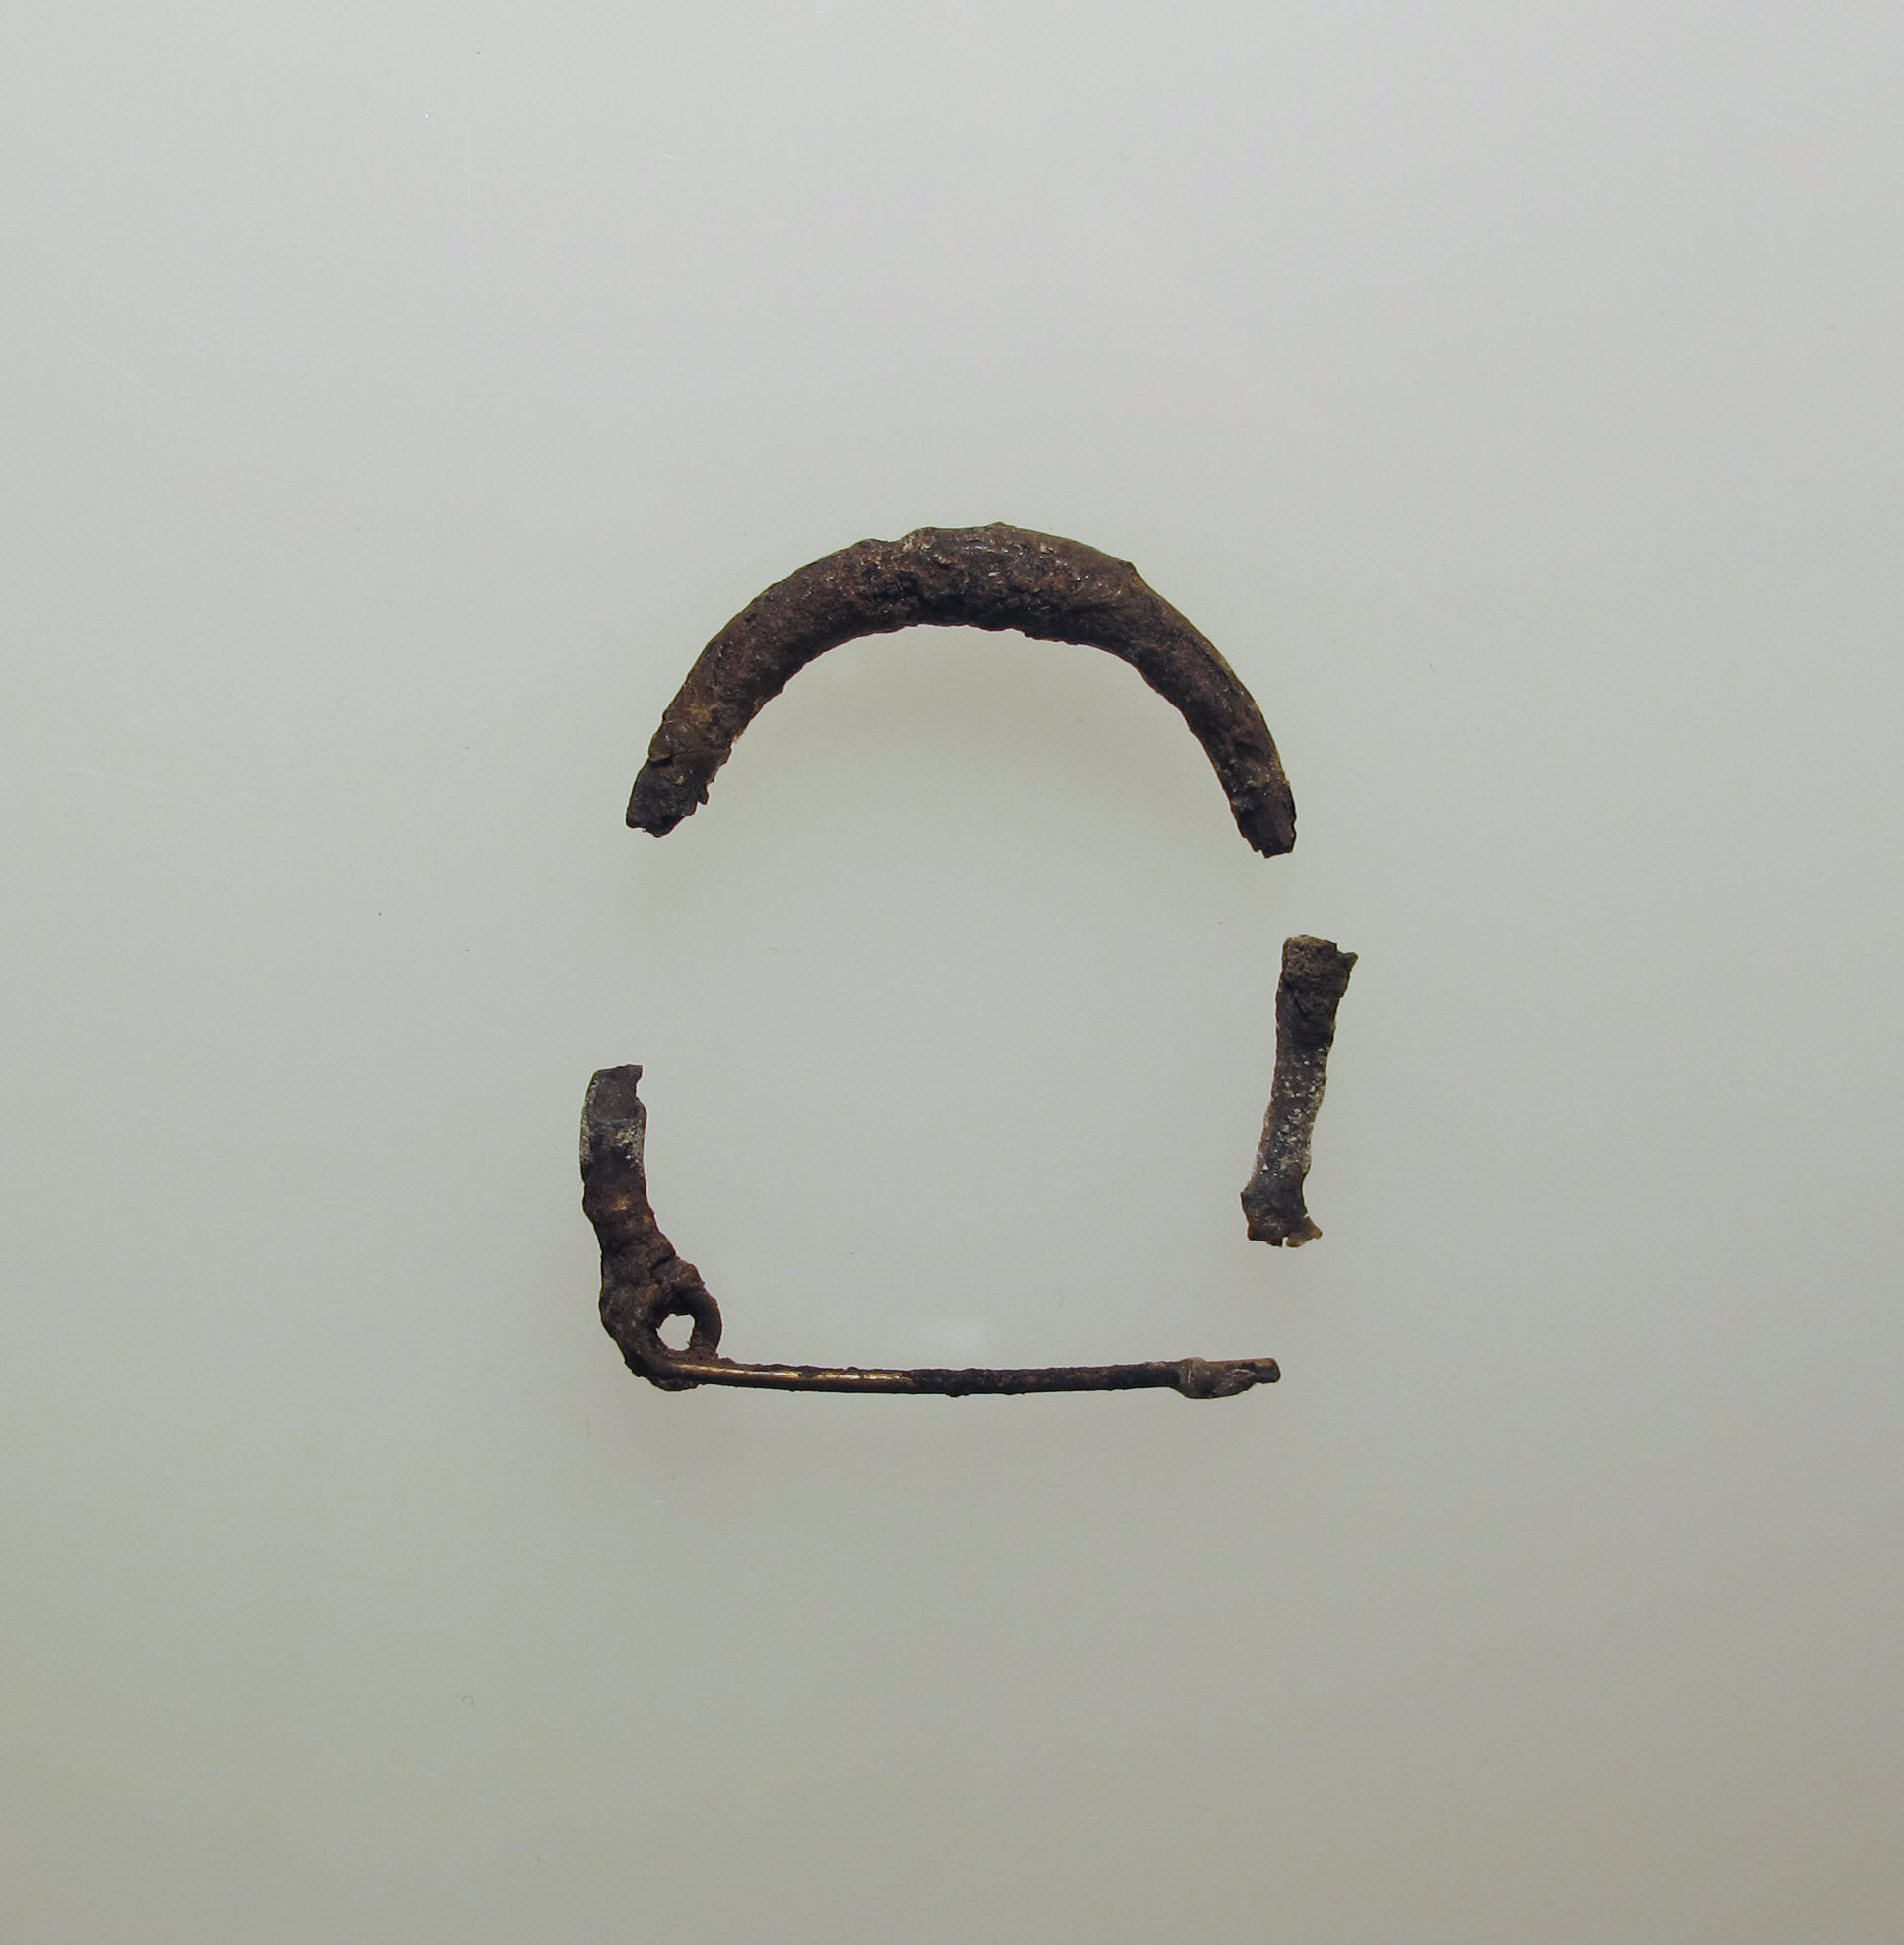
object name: fibula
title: Silver fibula (safety pin)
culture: cypriot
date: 3900 BCE-100 CE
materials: silver